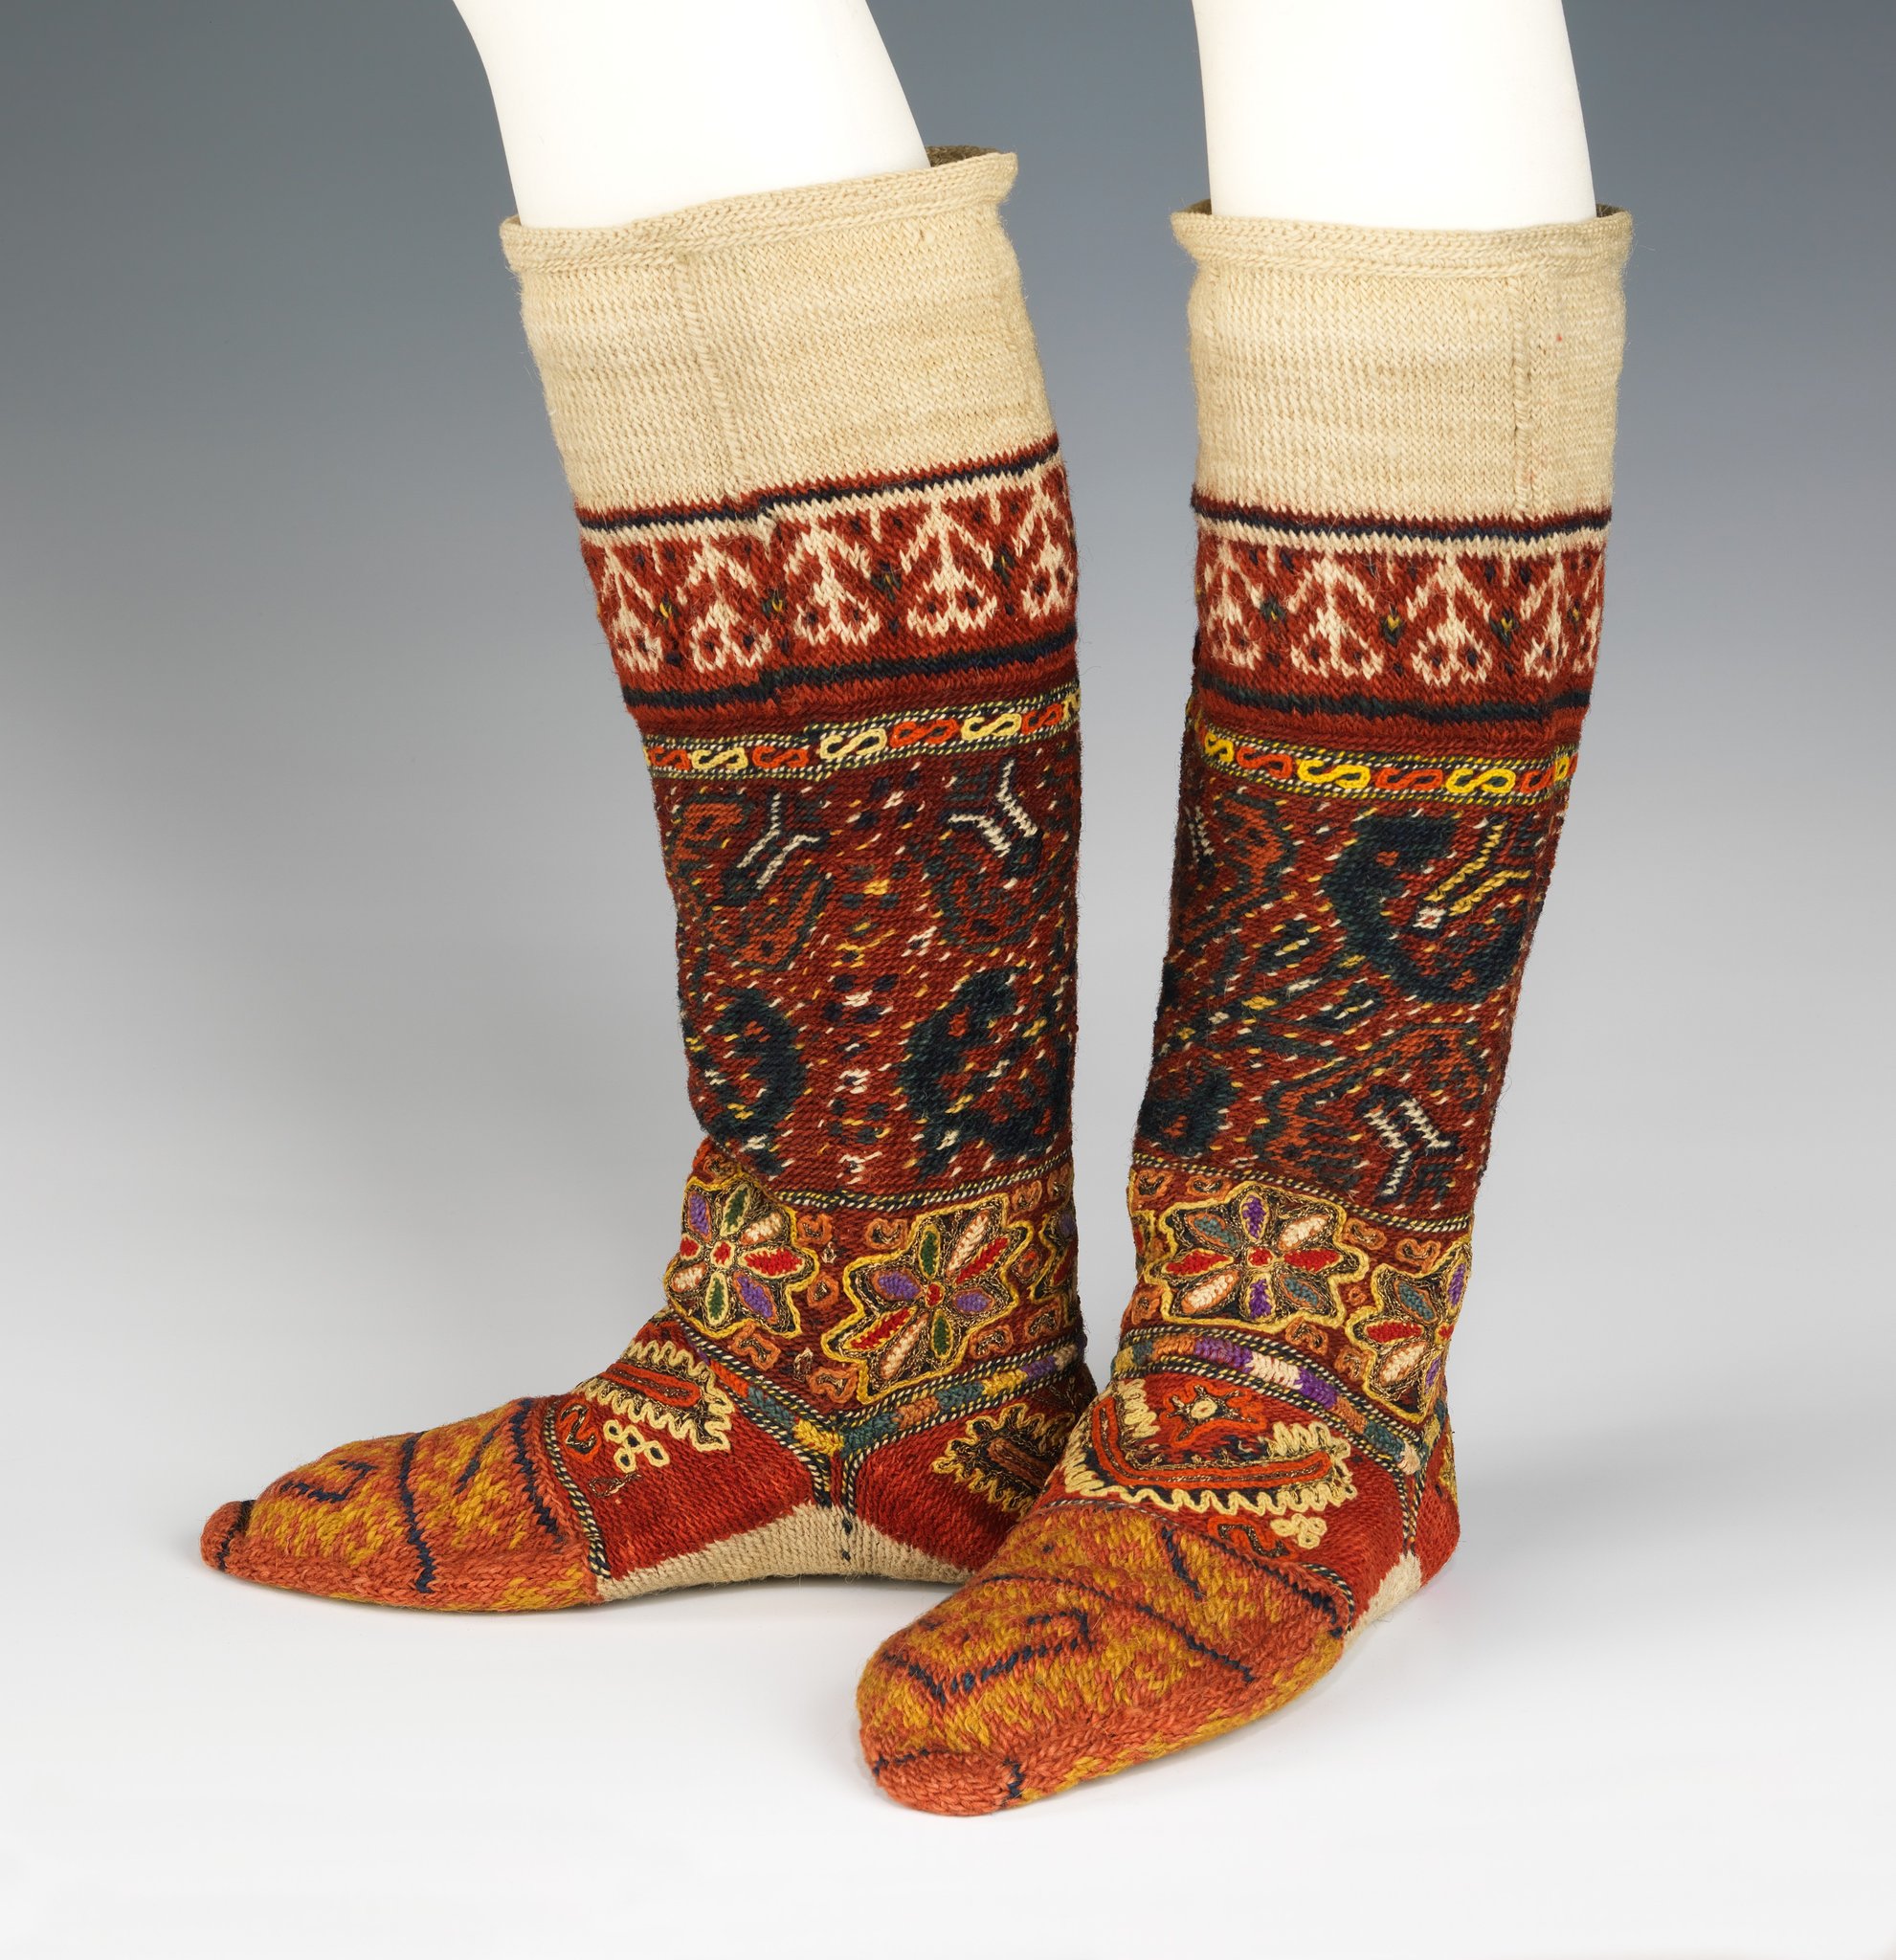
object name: sock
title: Socks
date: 1876-1900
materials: metal, wool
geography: macedonia